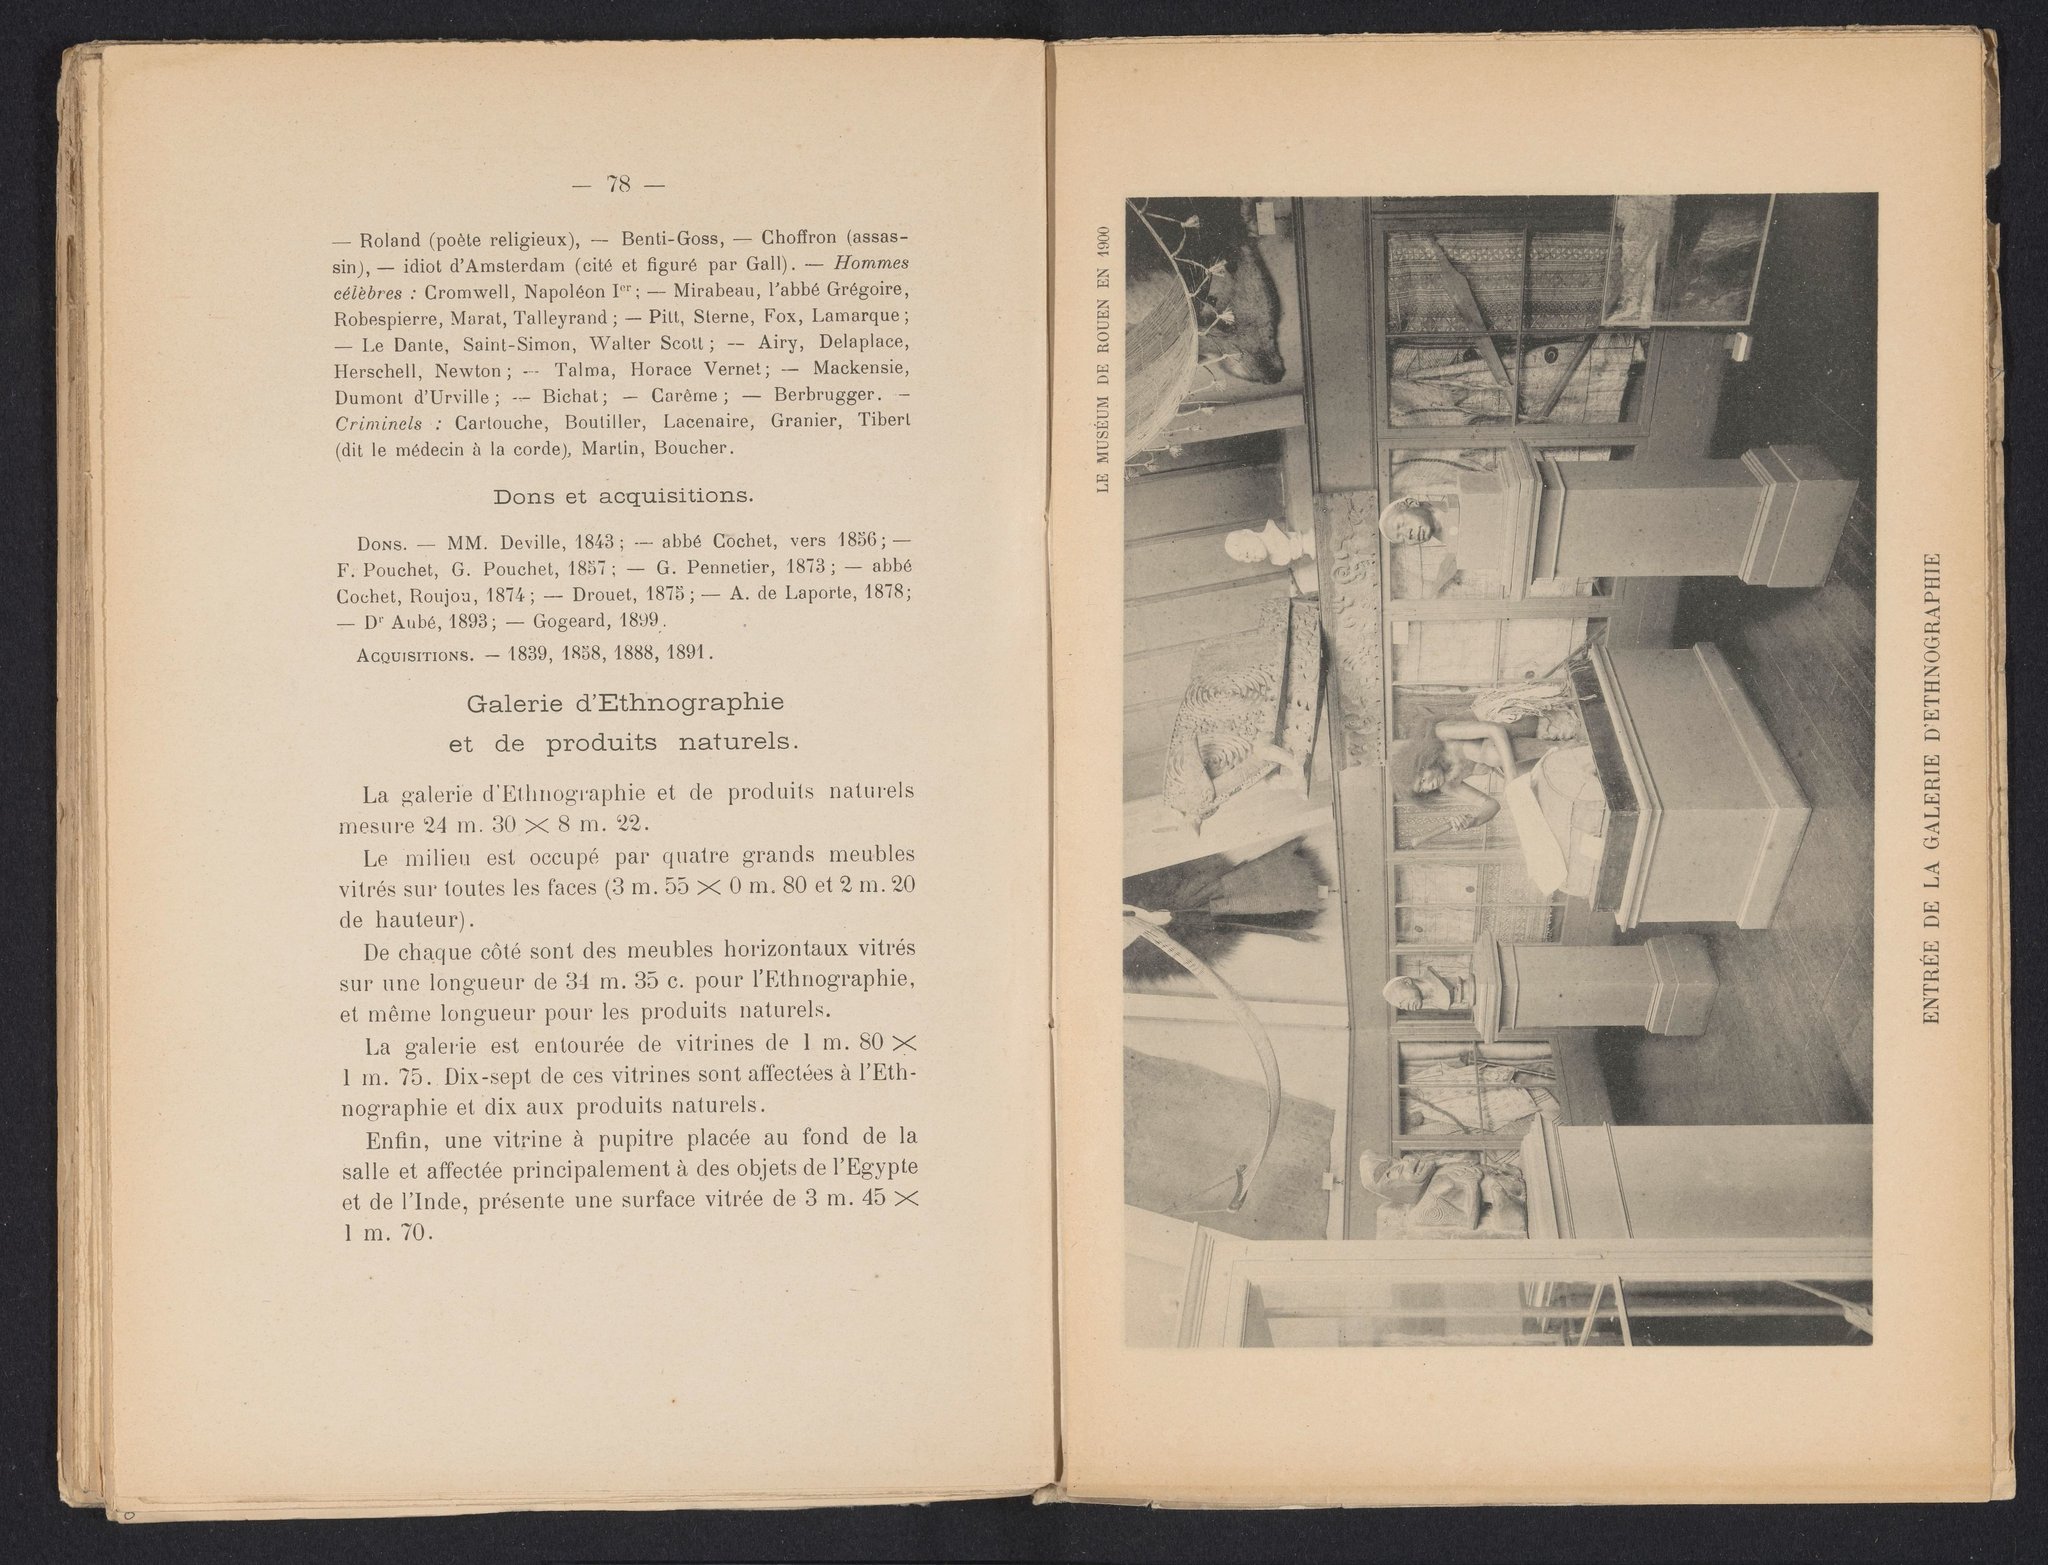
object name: photomechanical print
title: Entrée de la Galerie d'Ethnographie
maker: Anonymous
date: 1890-1900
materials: paper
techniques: photograph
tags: permanent exhibition, museum